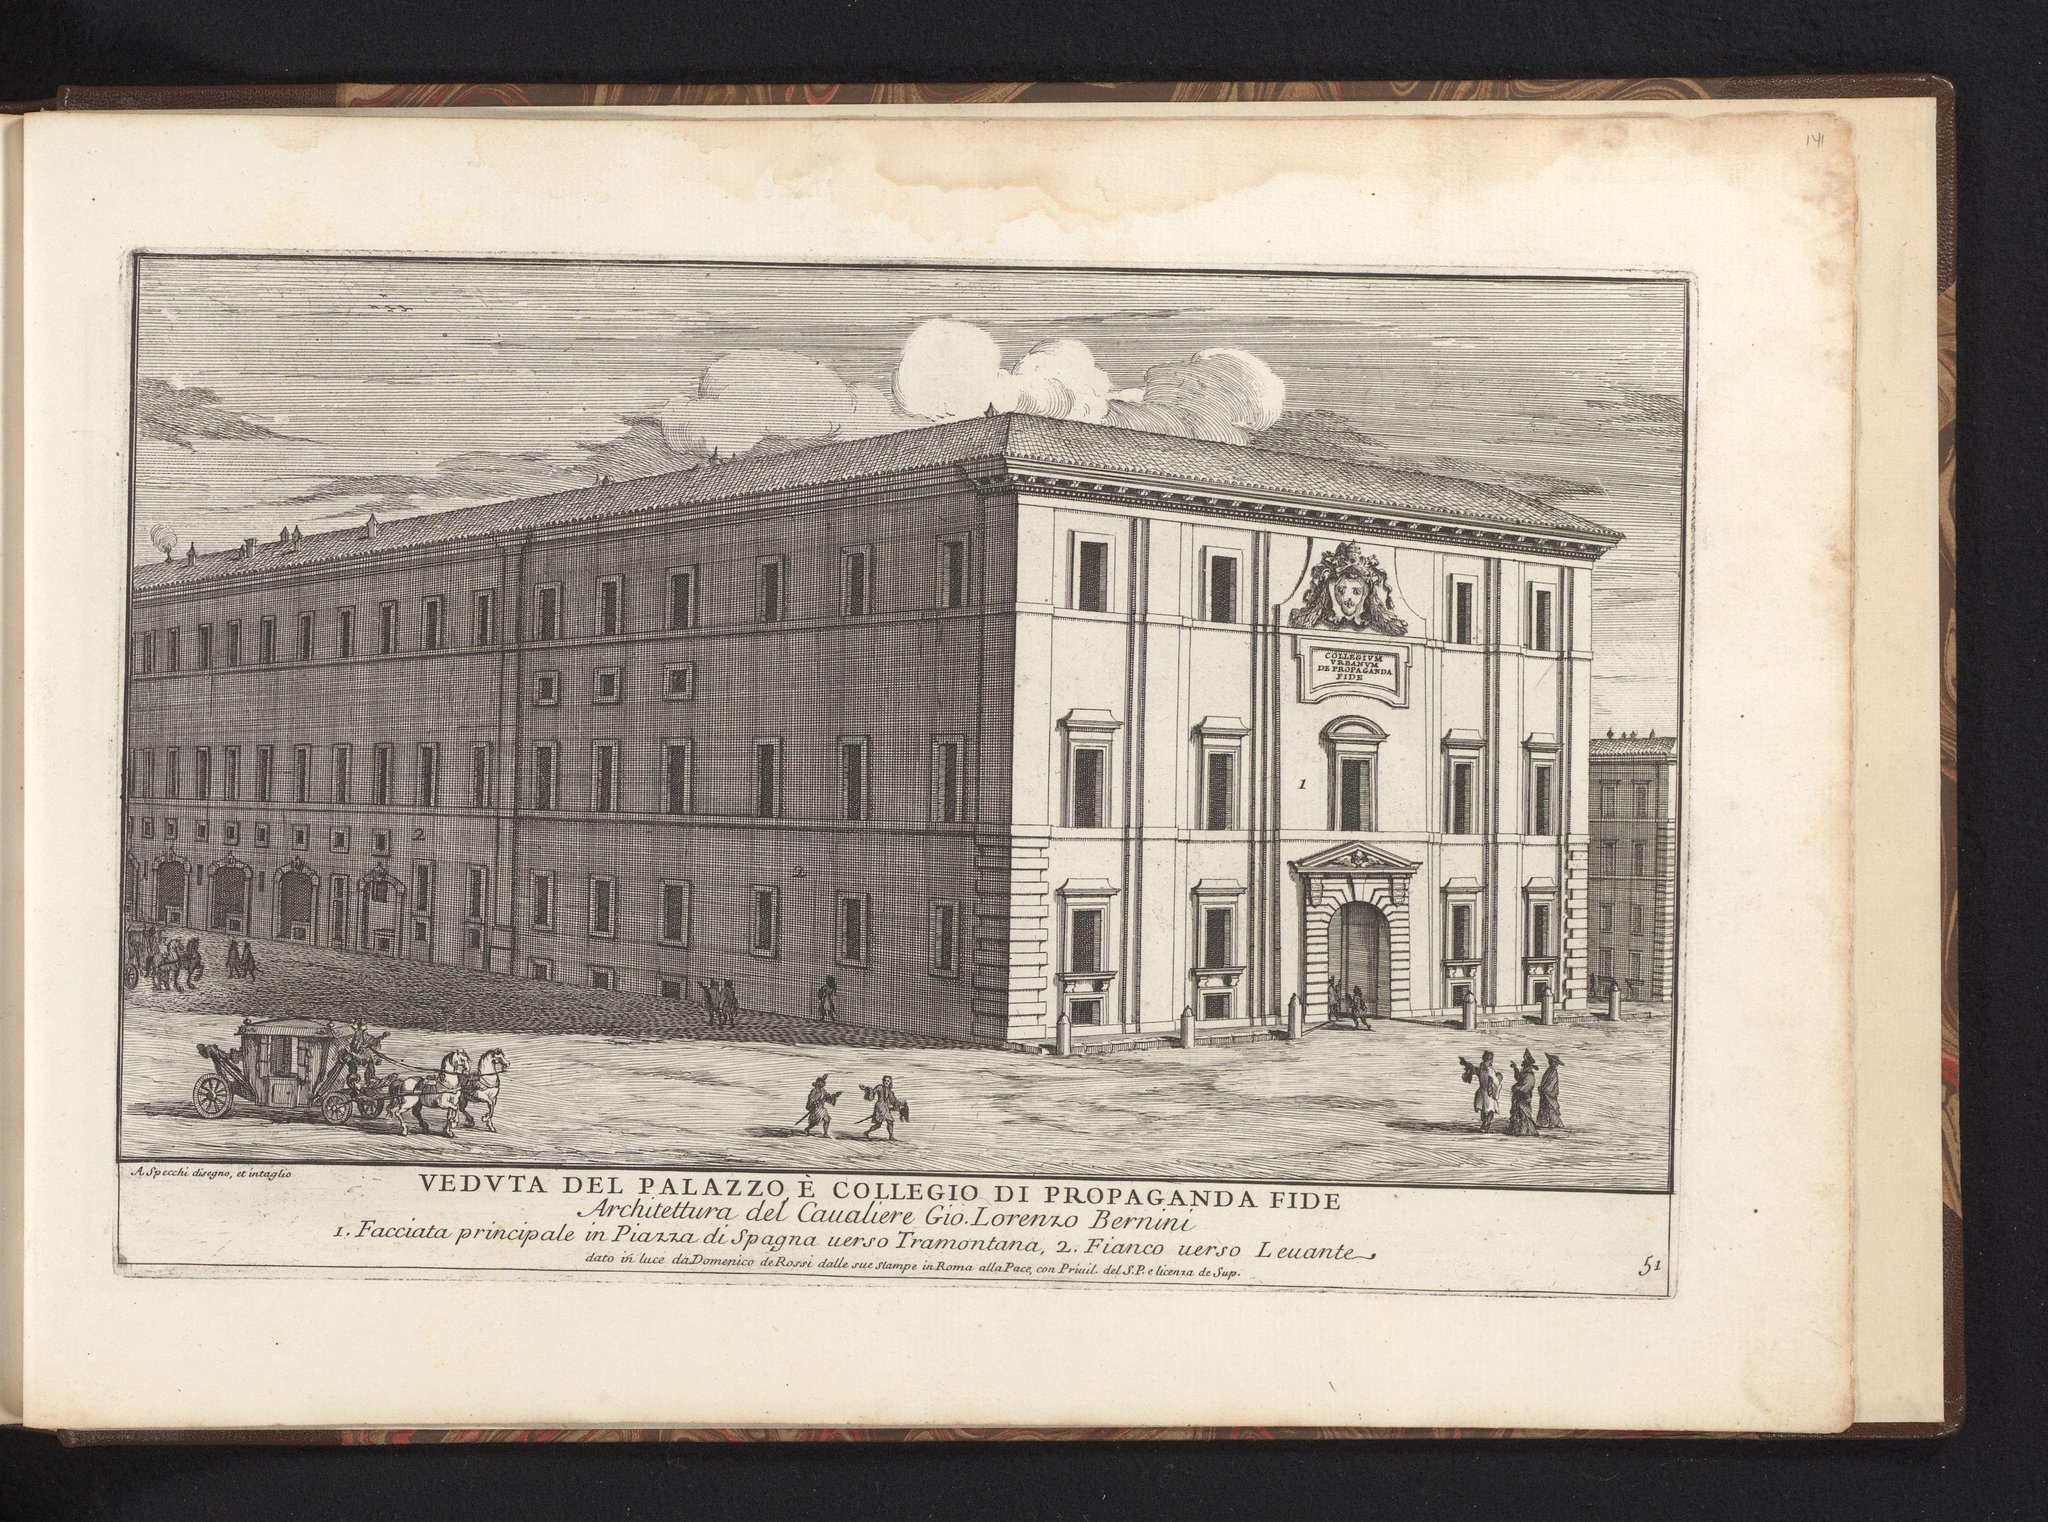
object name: album leaf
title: Collegio de Propaganda Fide te Rome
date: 1699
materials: paper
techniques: etching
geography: rome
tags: city-view, and landscape with man-made constructions, hôtel, i.e. small palace in city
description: Deze prent maakt deel uit van een reeks van 52 prenten met voorstellingen van paleizen in Rome. Samen met vier andere reeksen vormt het de grote reeks: 'Il nuovo teatro di Roma moderna'.